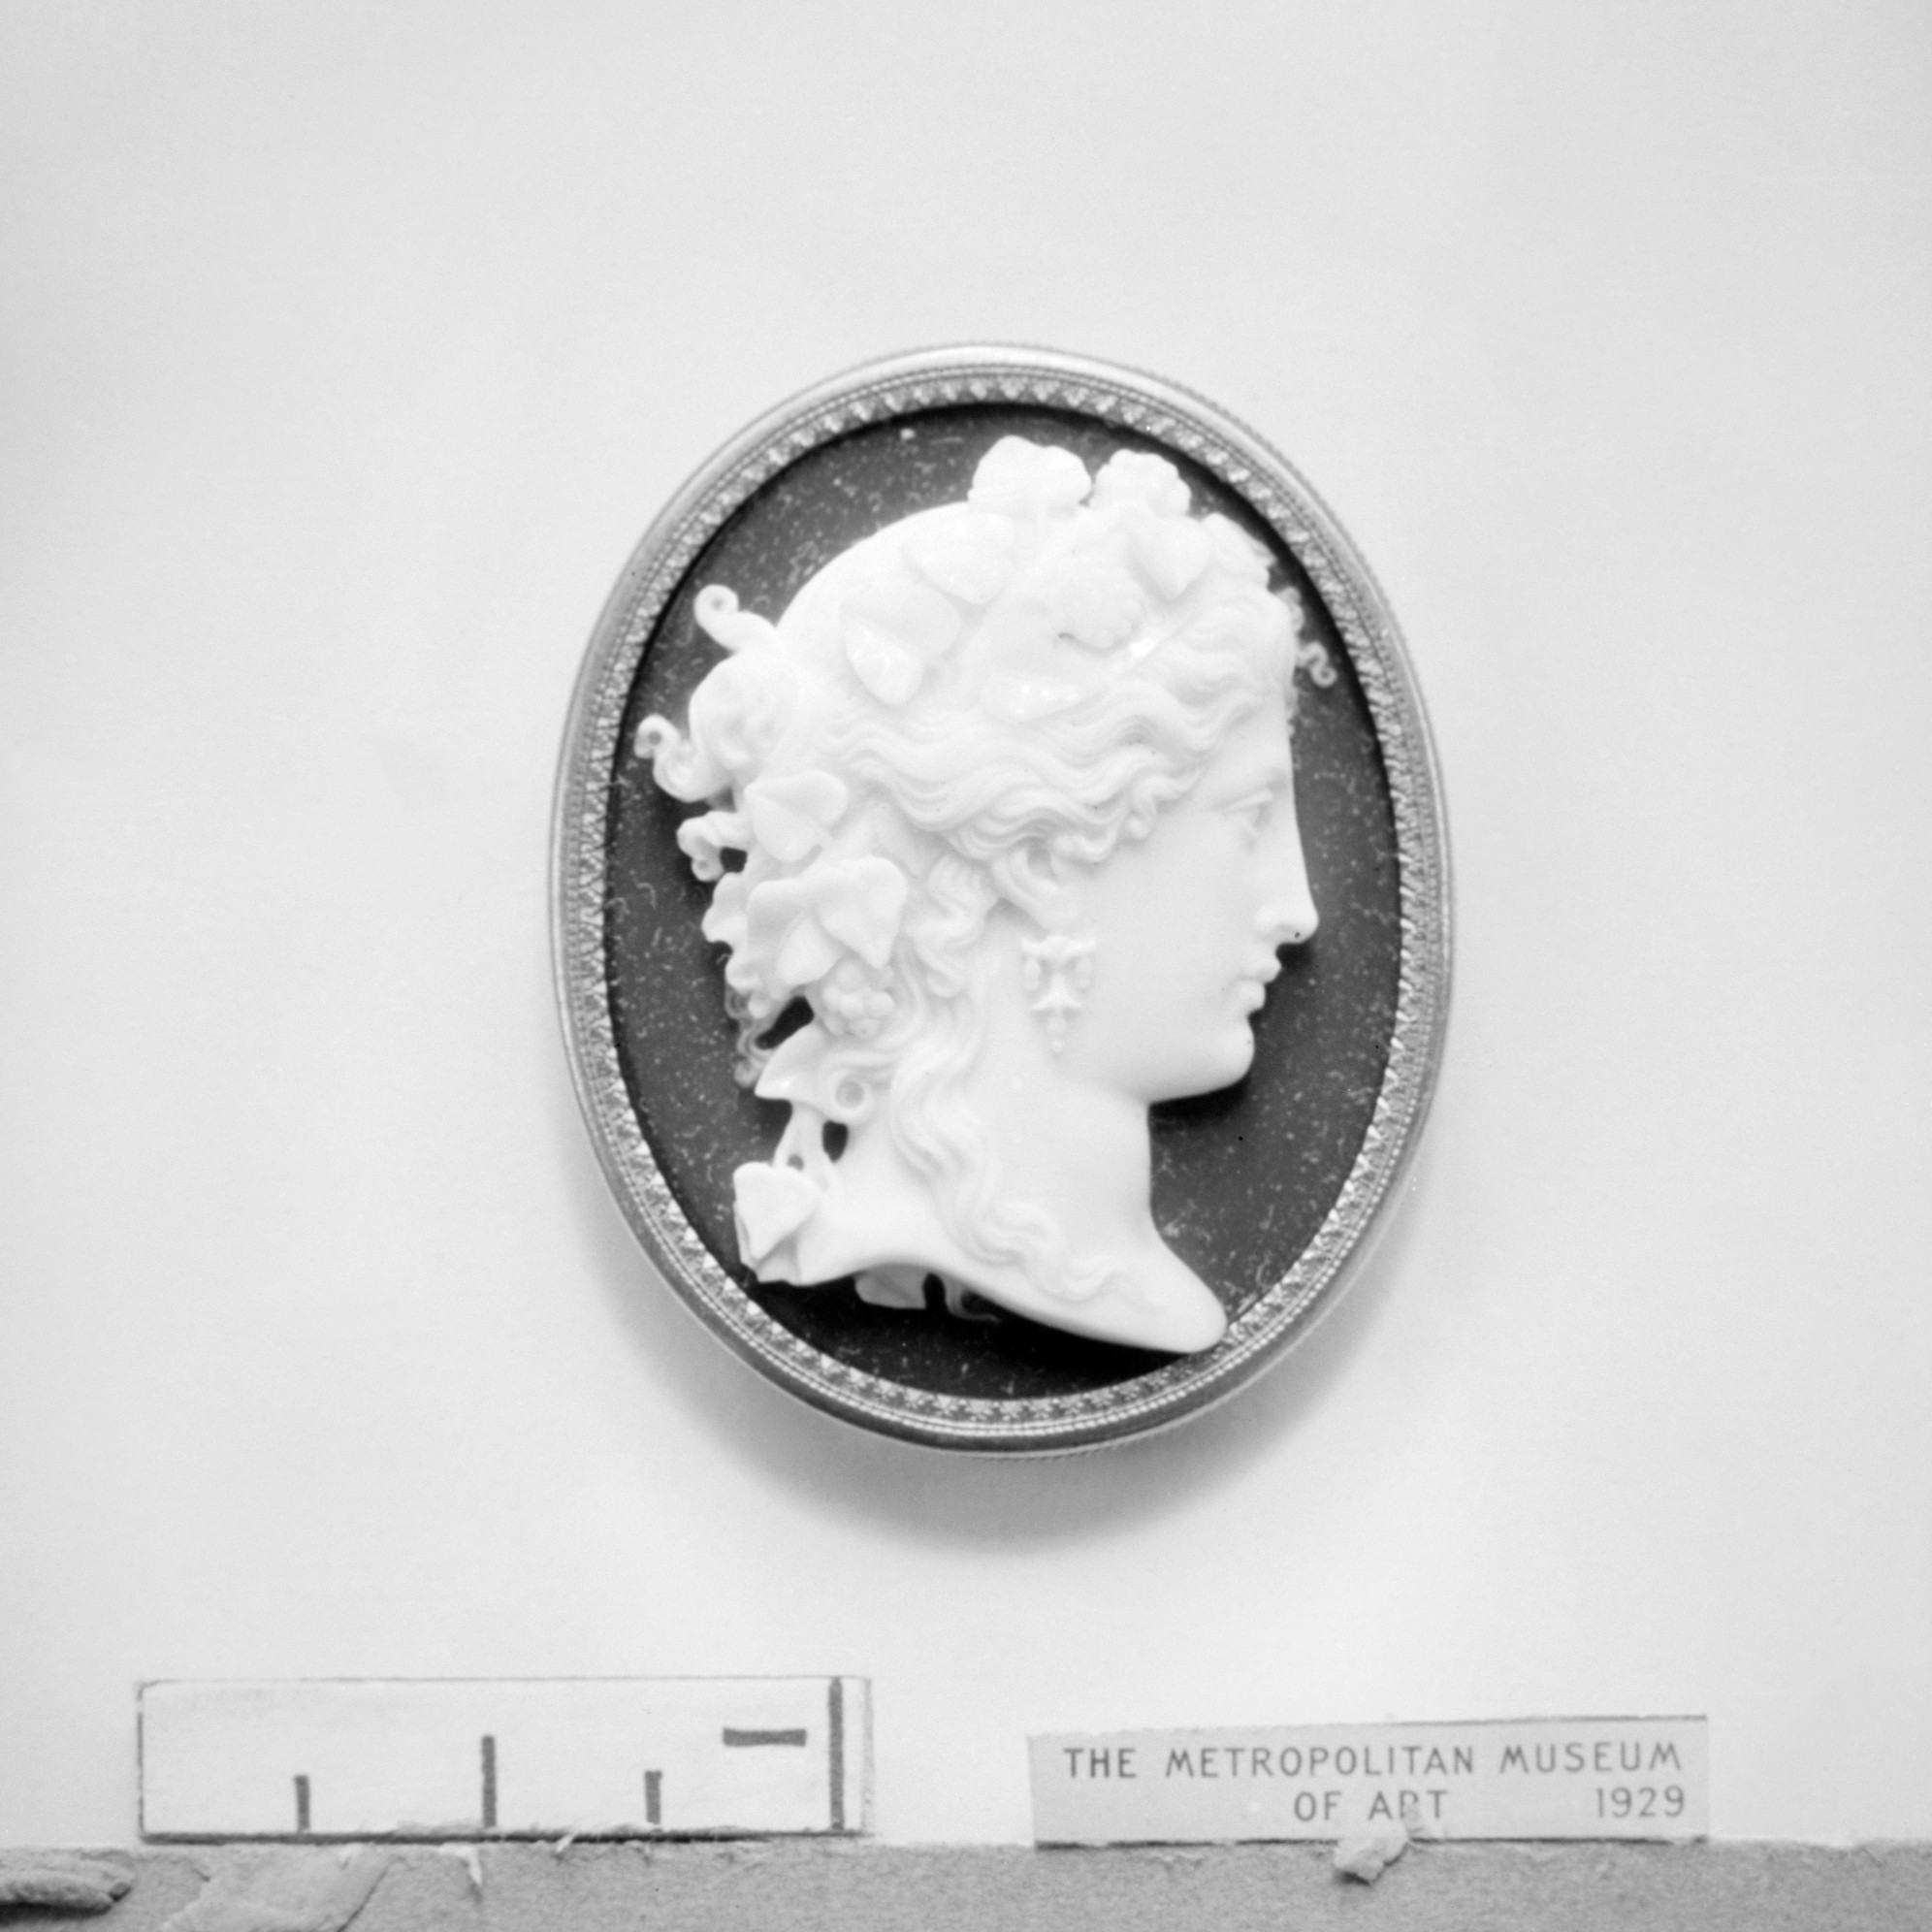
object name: cameo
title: Bacchante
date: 1834-1866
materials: gold, onyx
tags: profiles,women,bacchantes